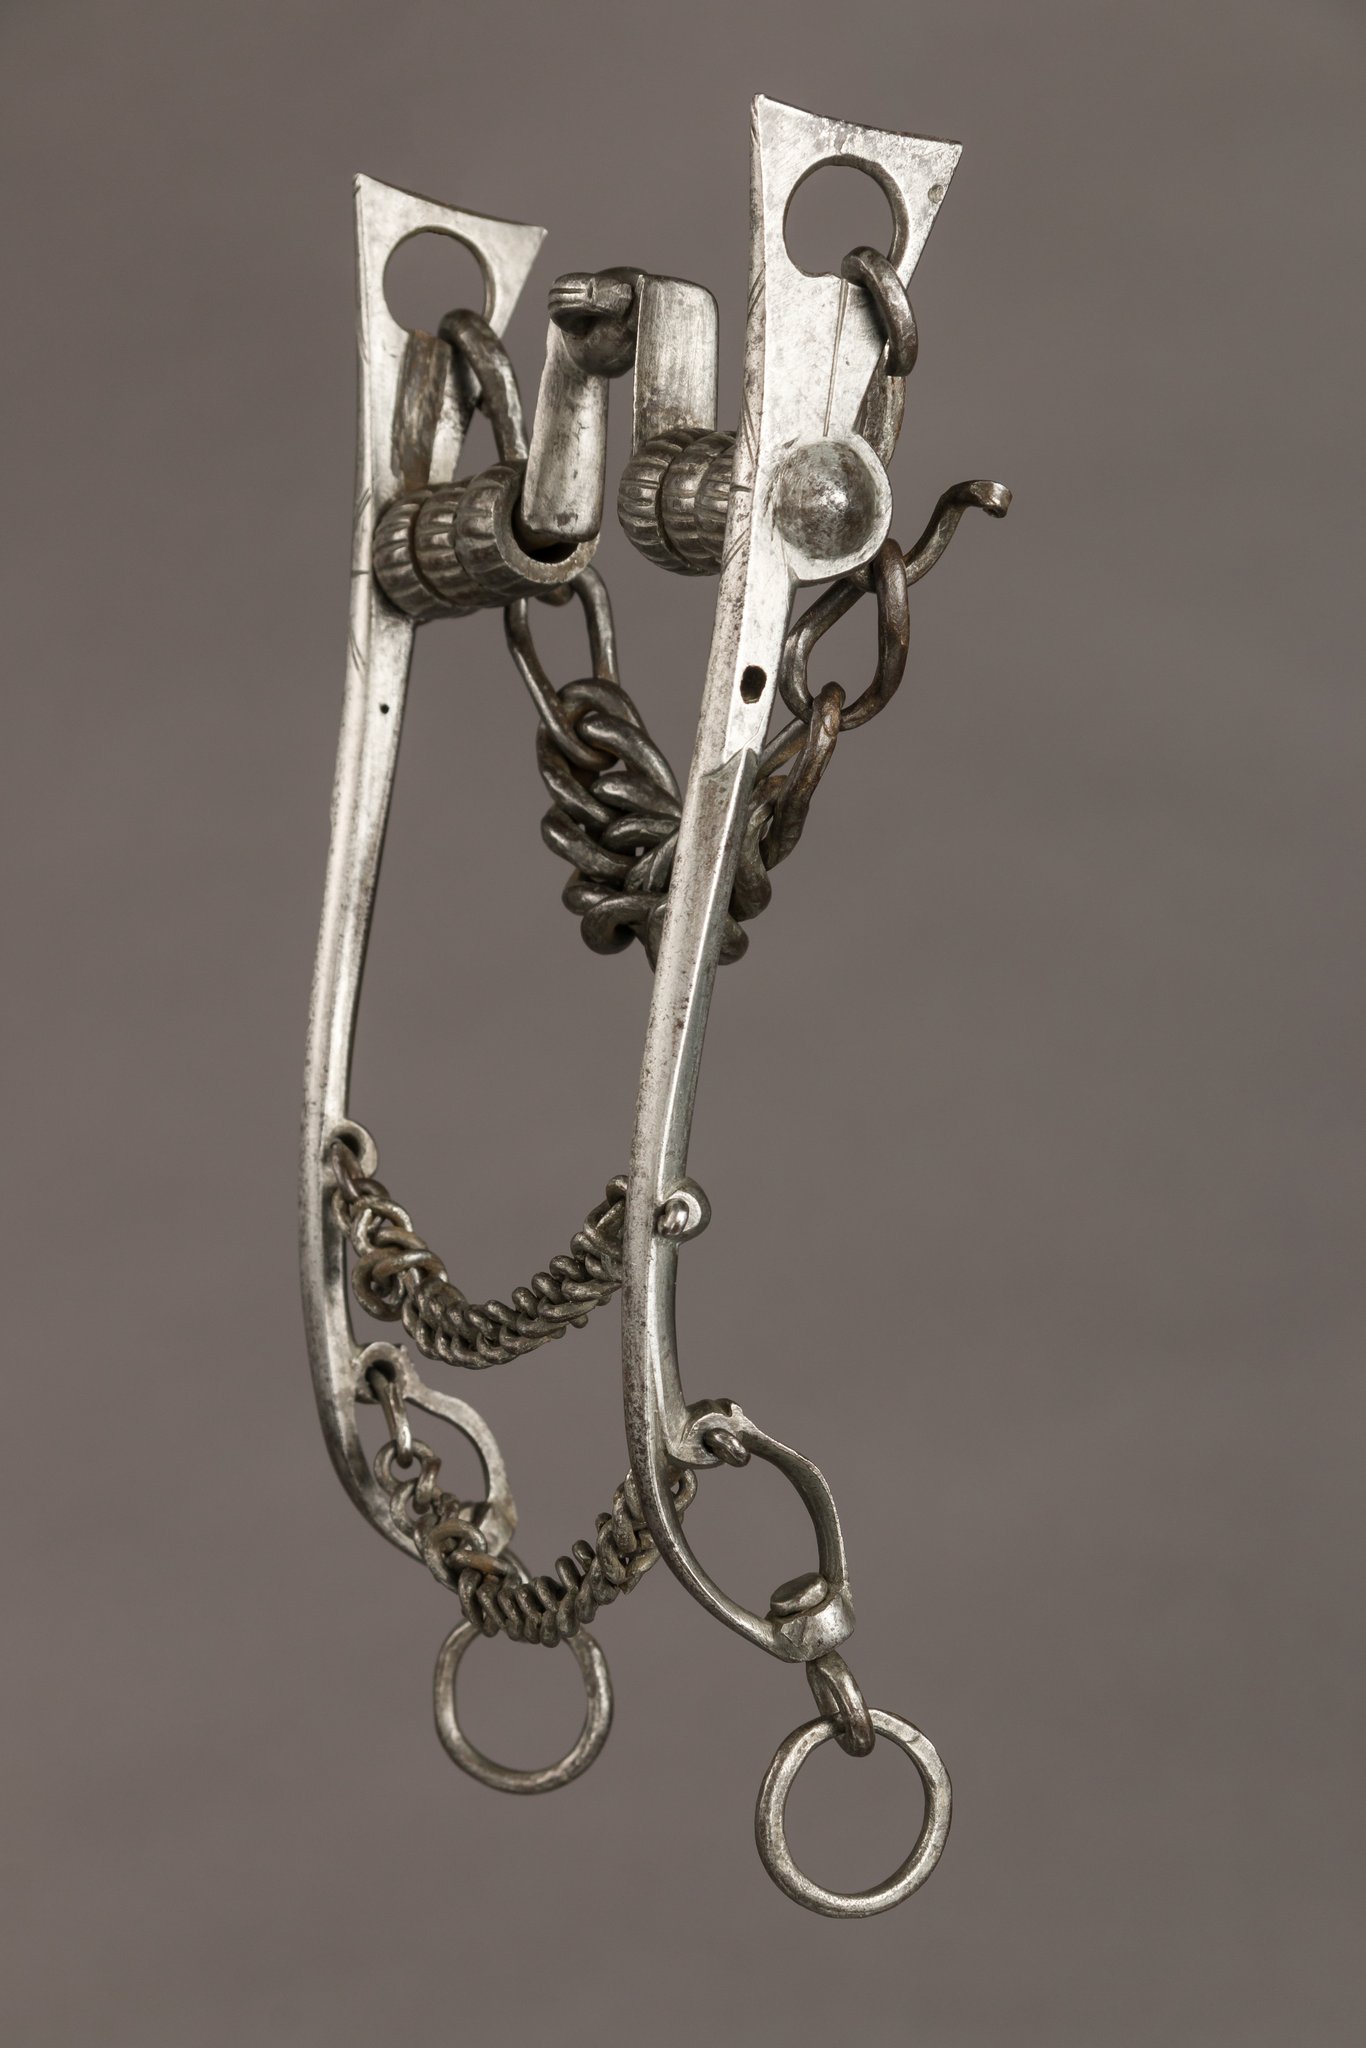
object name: bit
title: Curb Bit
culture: german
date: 1800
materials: metal alloy, tin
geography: germany